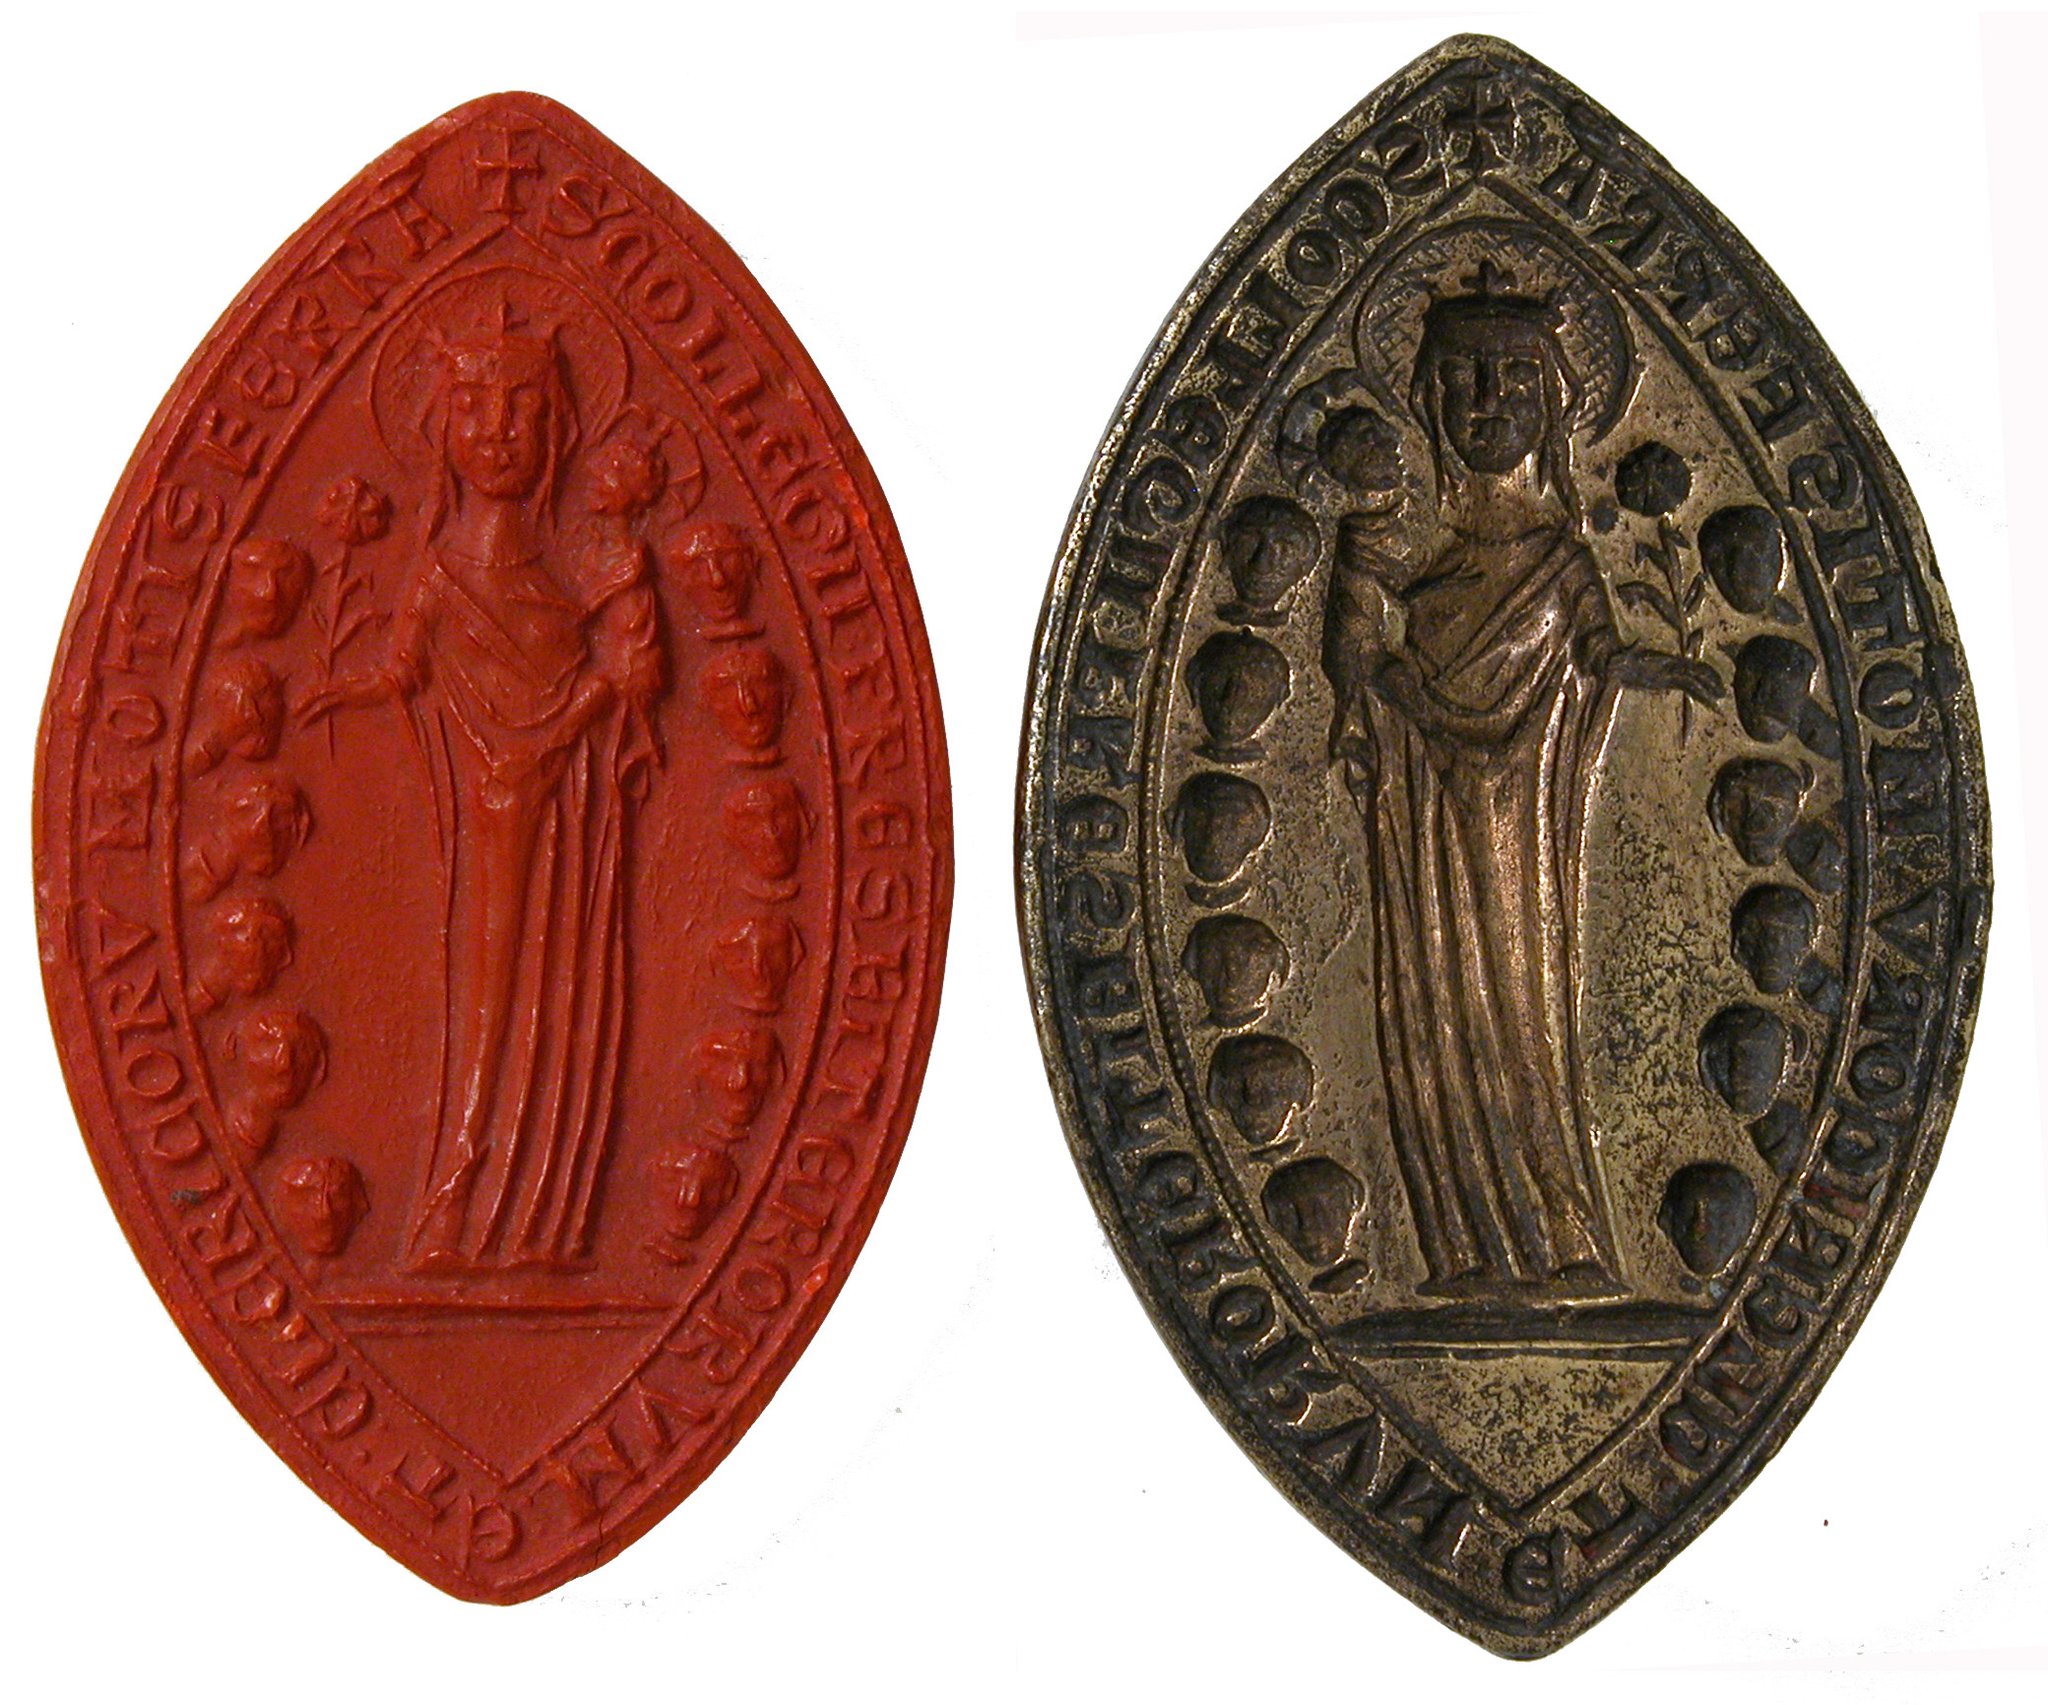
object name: seal matrix and impression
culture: french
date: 1401-1500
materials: bronze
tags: madonna and child